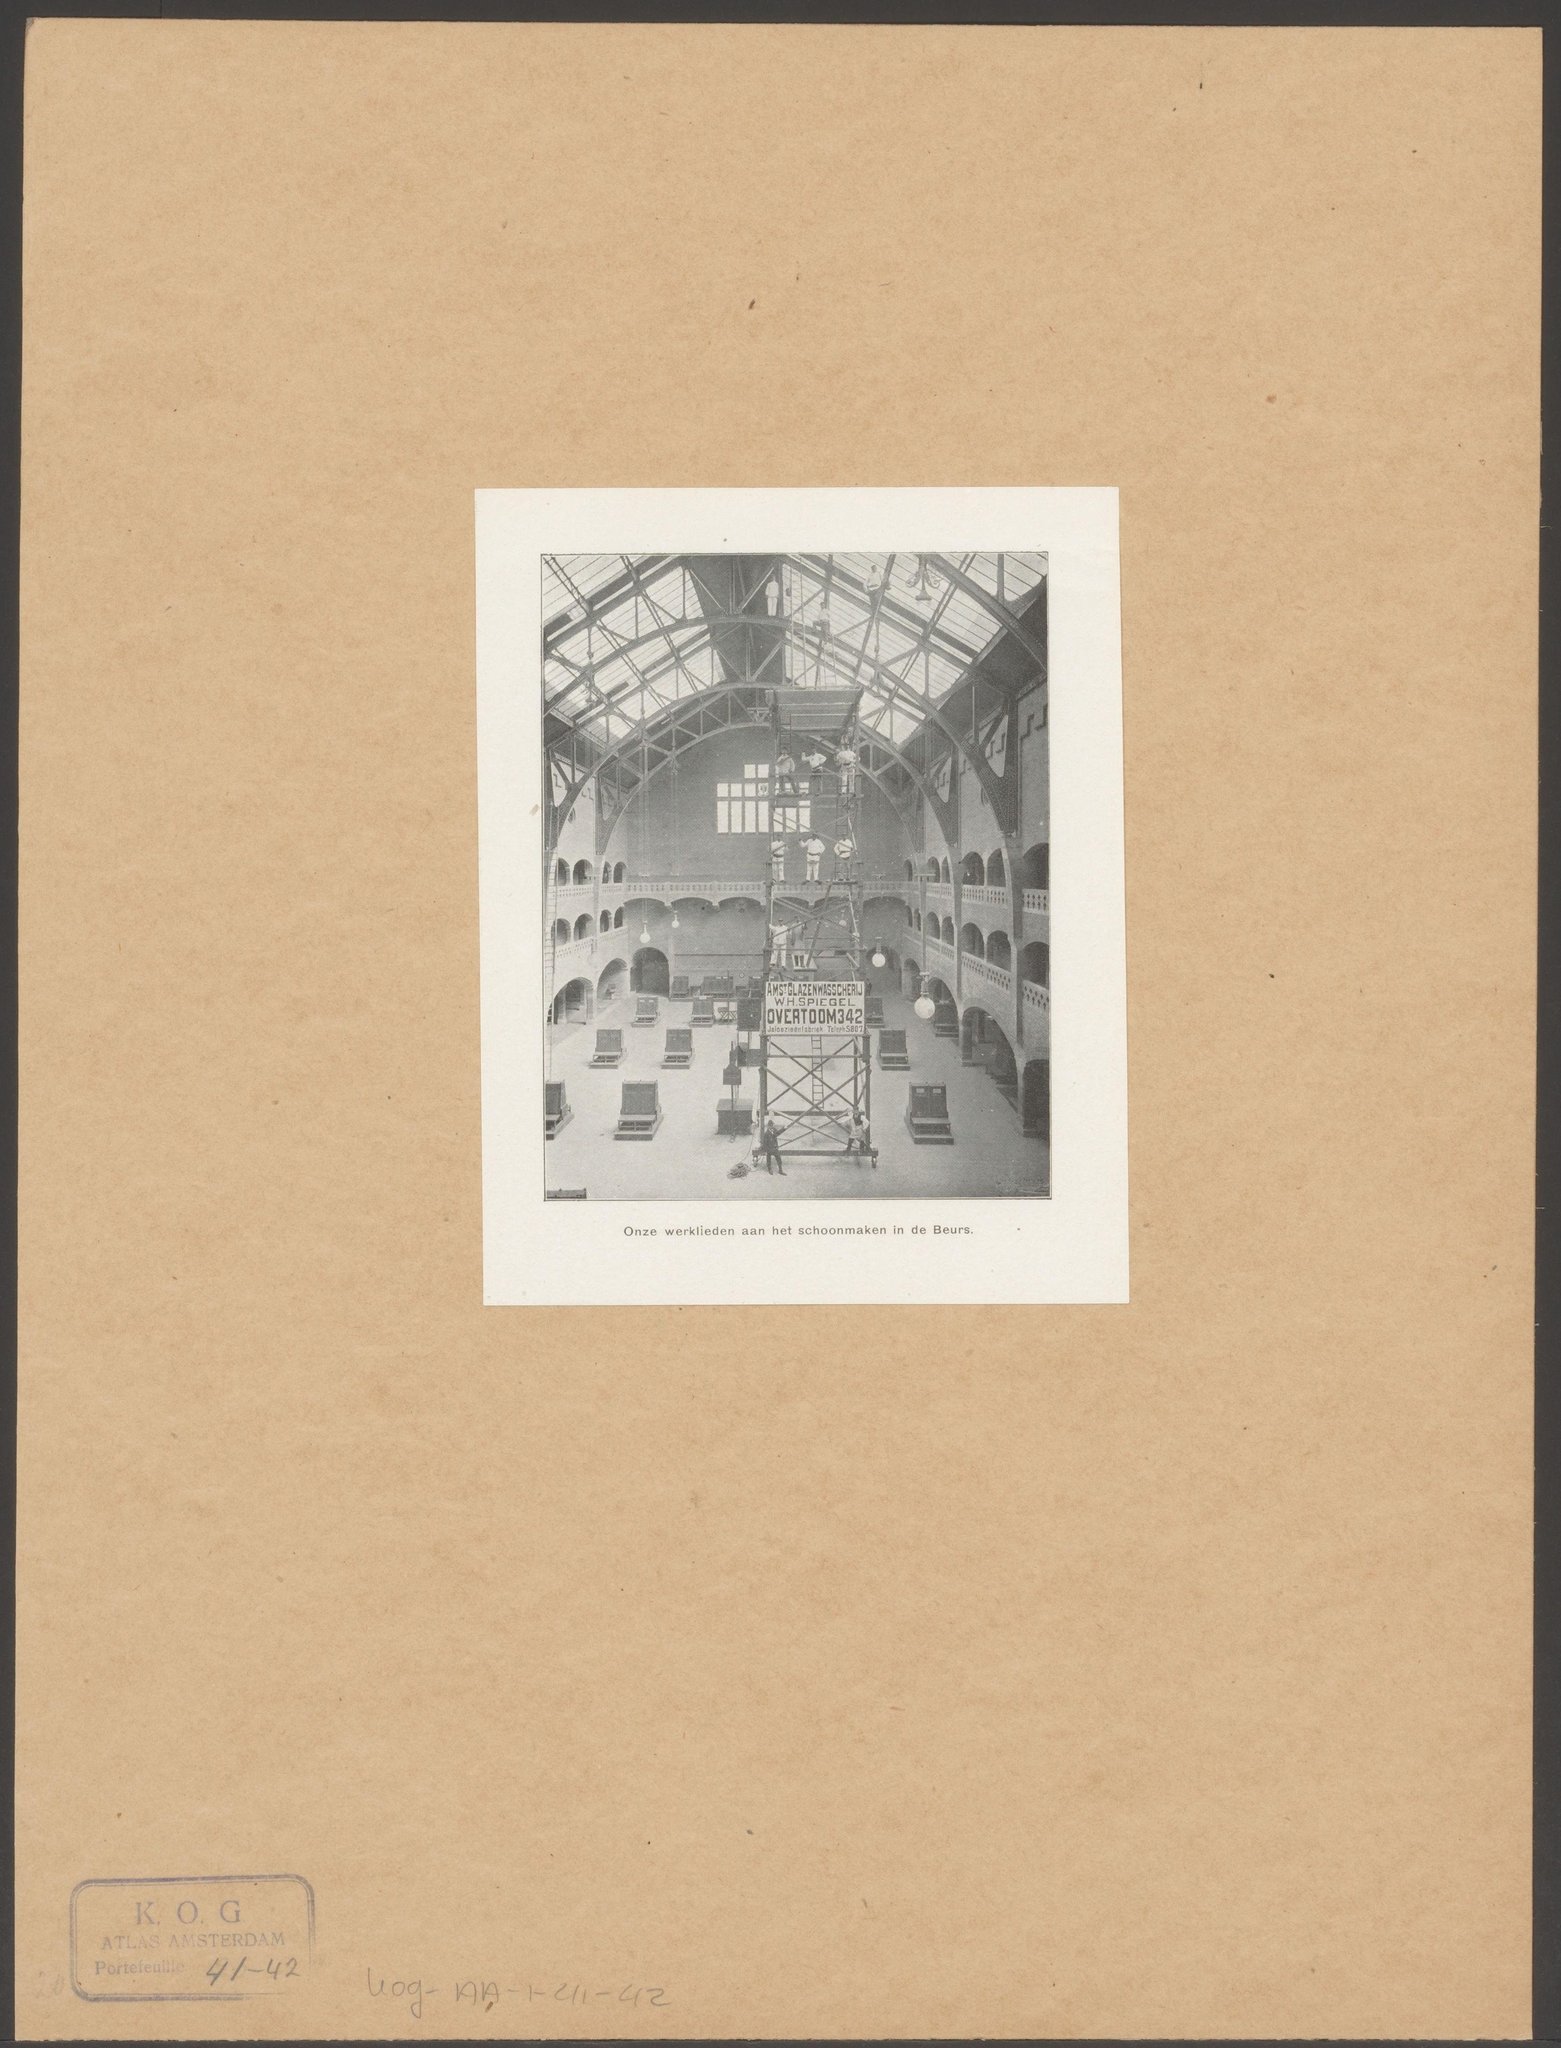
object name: photomechanical print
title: Onze werklieden aan het schoonmaken in de Beurs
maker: Anonymous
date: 1903-1905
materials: paper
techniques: letterpress printing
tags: stock exchange, stock-market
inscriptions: collector's mark: Lugt 1461b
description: Onderwerpsrubriek binnen de Atlas Amsterdam: B. Beurs op het Damrak.